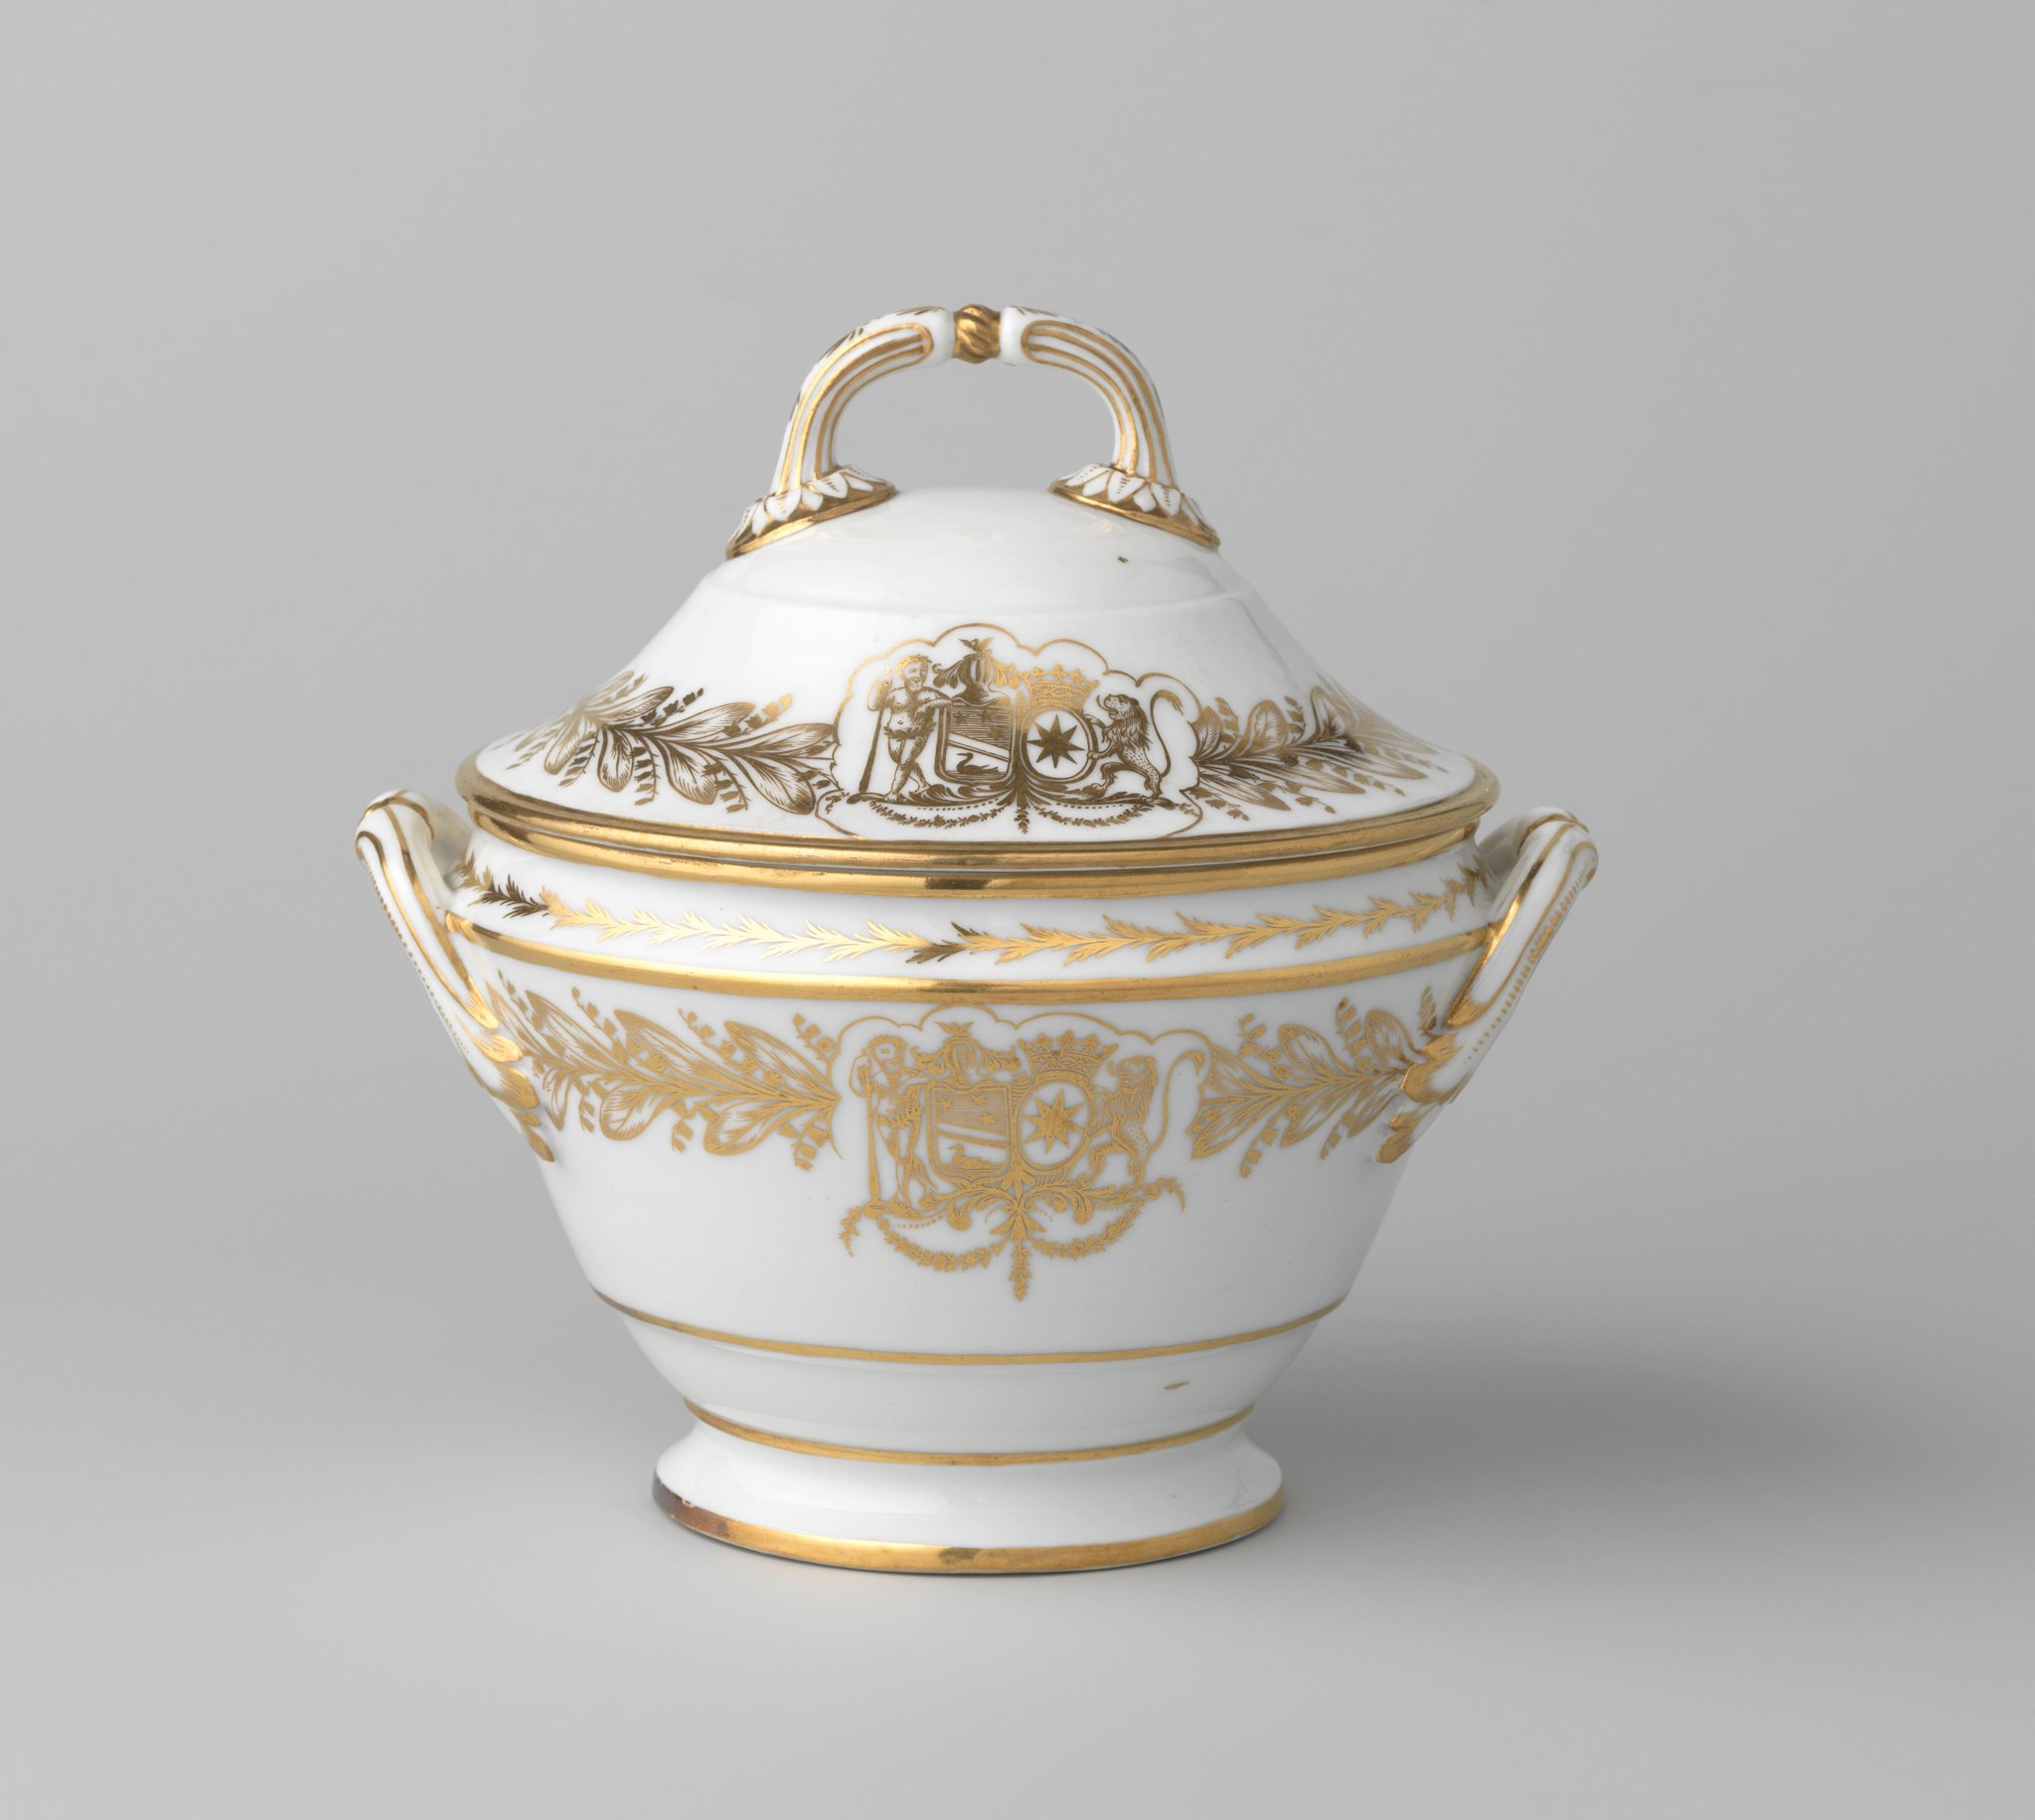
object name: tureen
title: Tureen with the coat of arms of Hendrik Peter Godfried Quack and Isabella Gertraud von Carnap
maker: Anonymous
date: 1790-1800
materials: glaze, gold, paint, porcelain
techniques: firing, forming, gilding, turning, vitrification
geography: paris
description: Terrine van porselein op hoge voet en met twee handvatten, beschilderd op het glazuur met goud. Op de buitenwand het alliantiewapen van Hendrik Peter Godfried Quack en Isabella Gertraud von Carnap en een bloemrank. De schouder met een bladrank. Gouden banden op de voet en rand. De handvatten zijn in de vorm van gemodelleerde en met goud aangezette bladranken. De deksel met dezelfde decoratie.